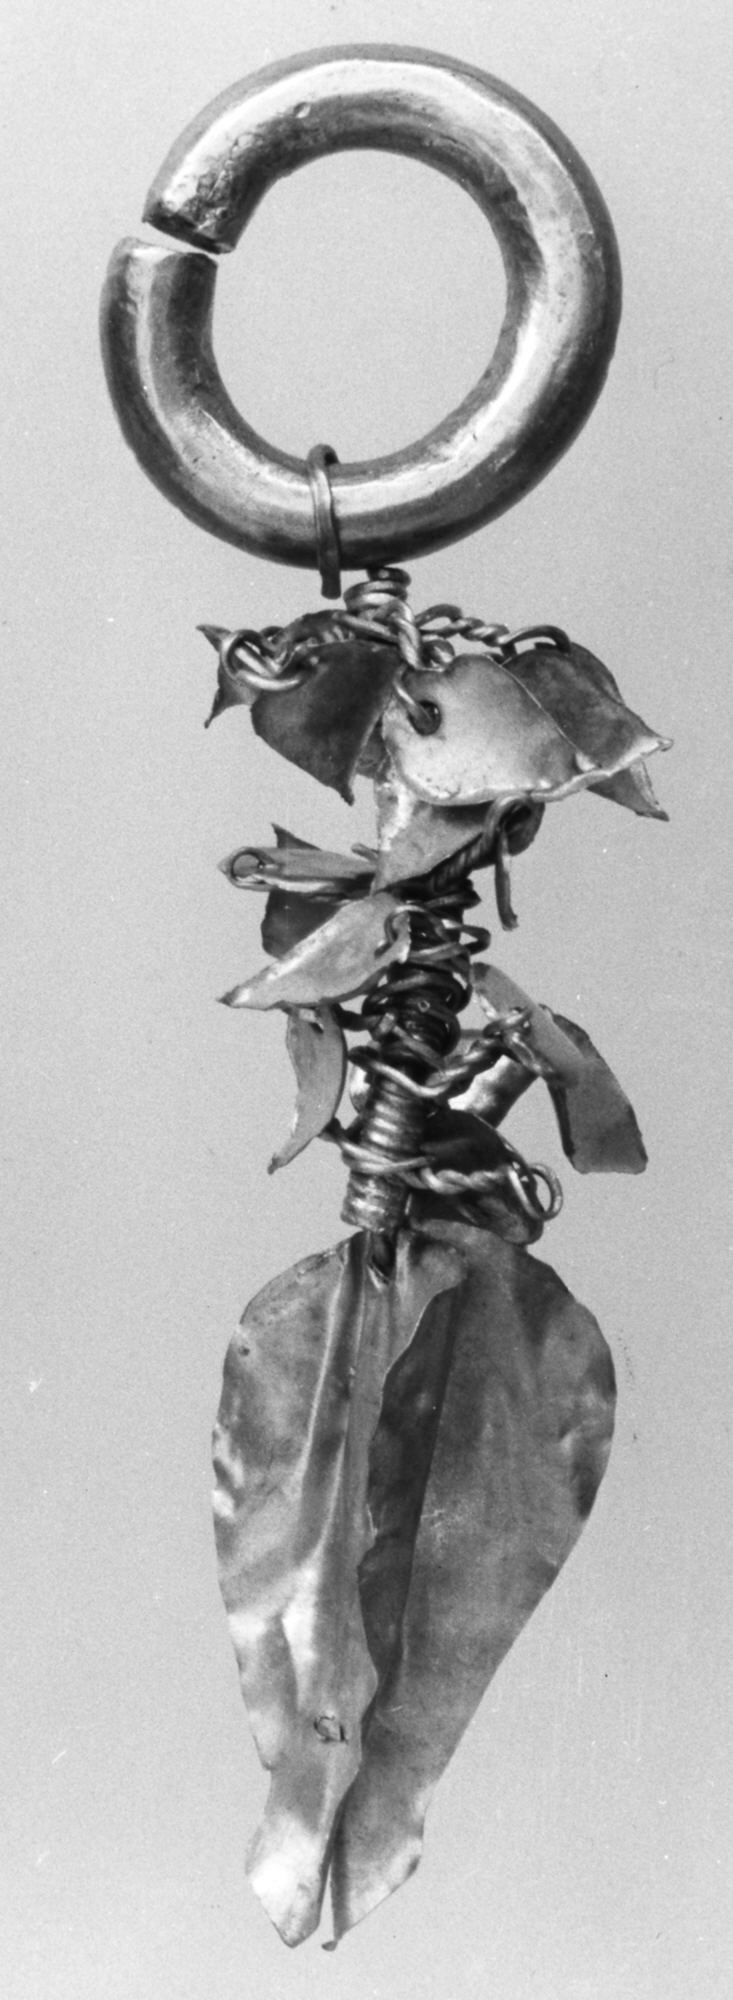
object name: earring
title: Earring (One of a Pair)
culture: korean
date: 401-600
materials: gold